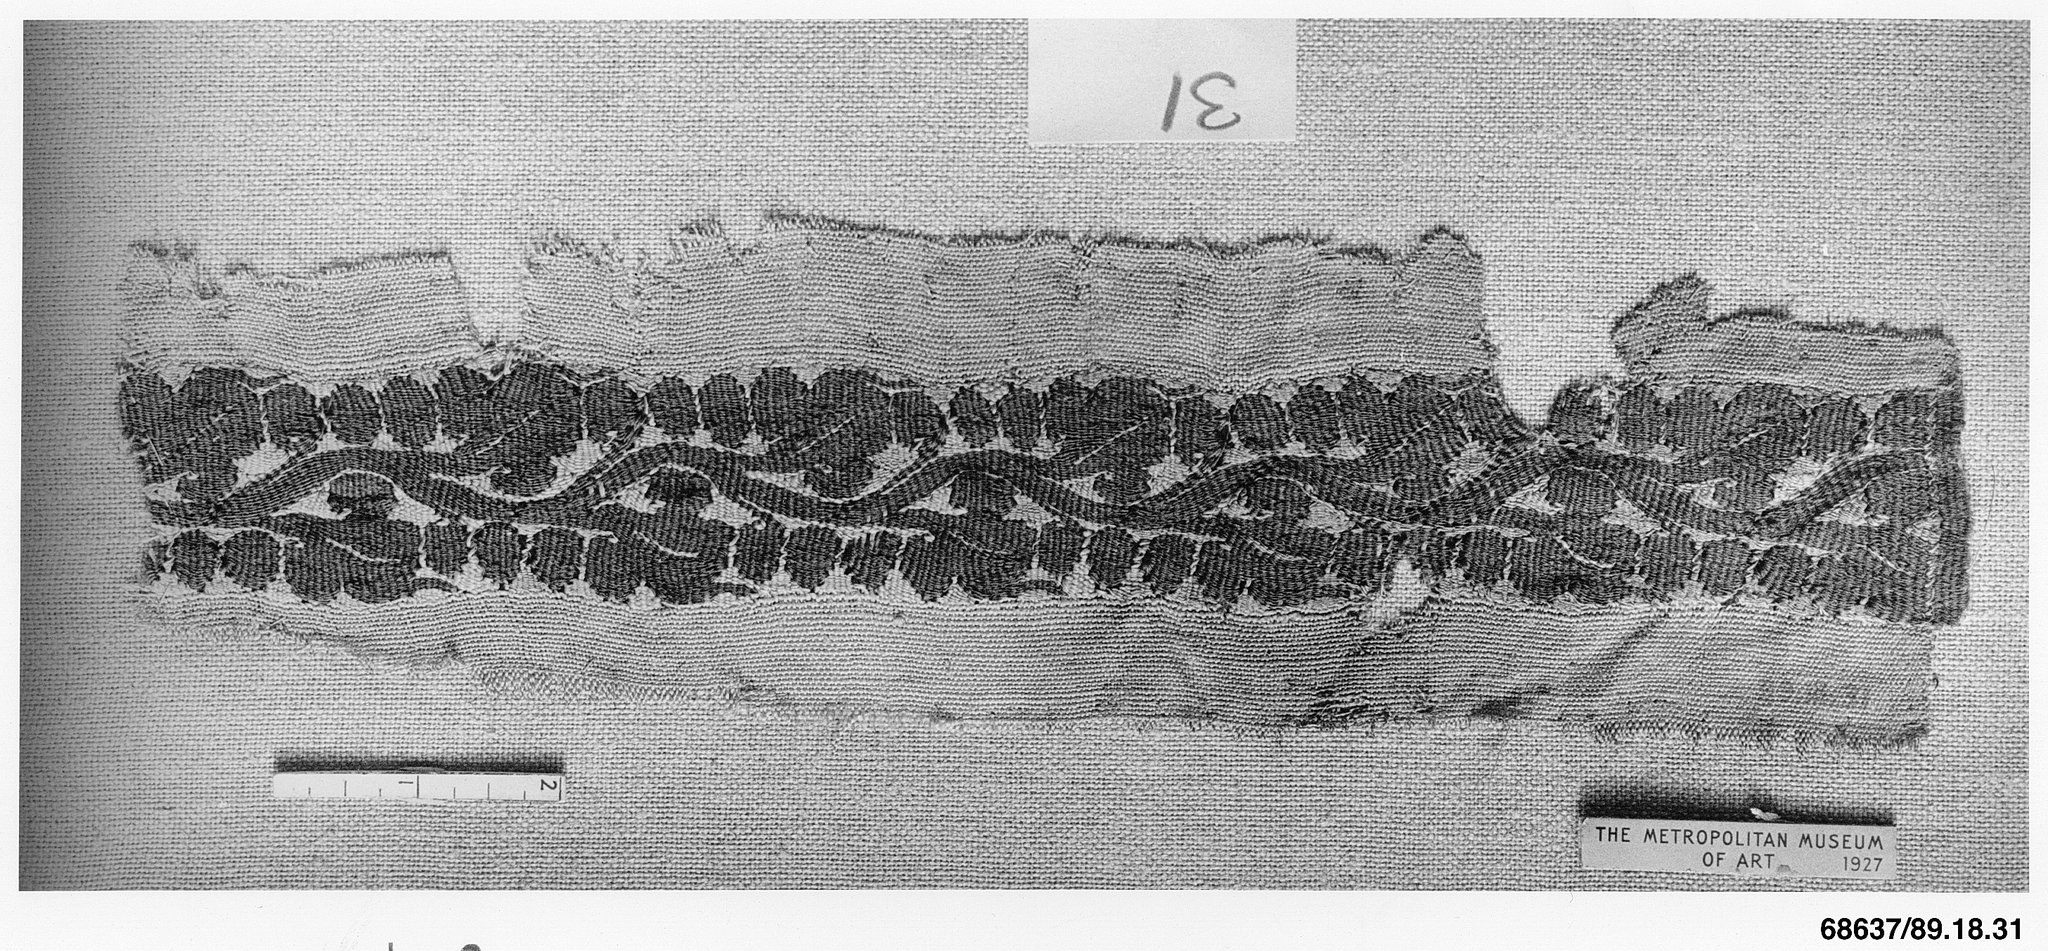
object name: textile fragment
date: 201-400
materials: linen, wool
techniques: weave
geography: egypt